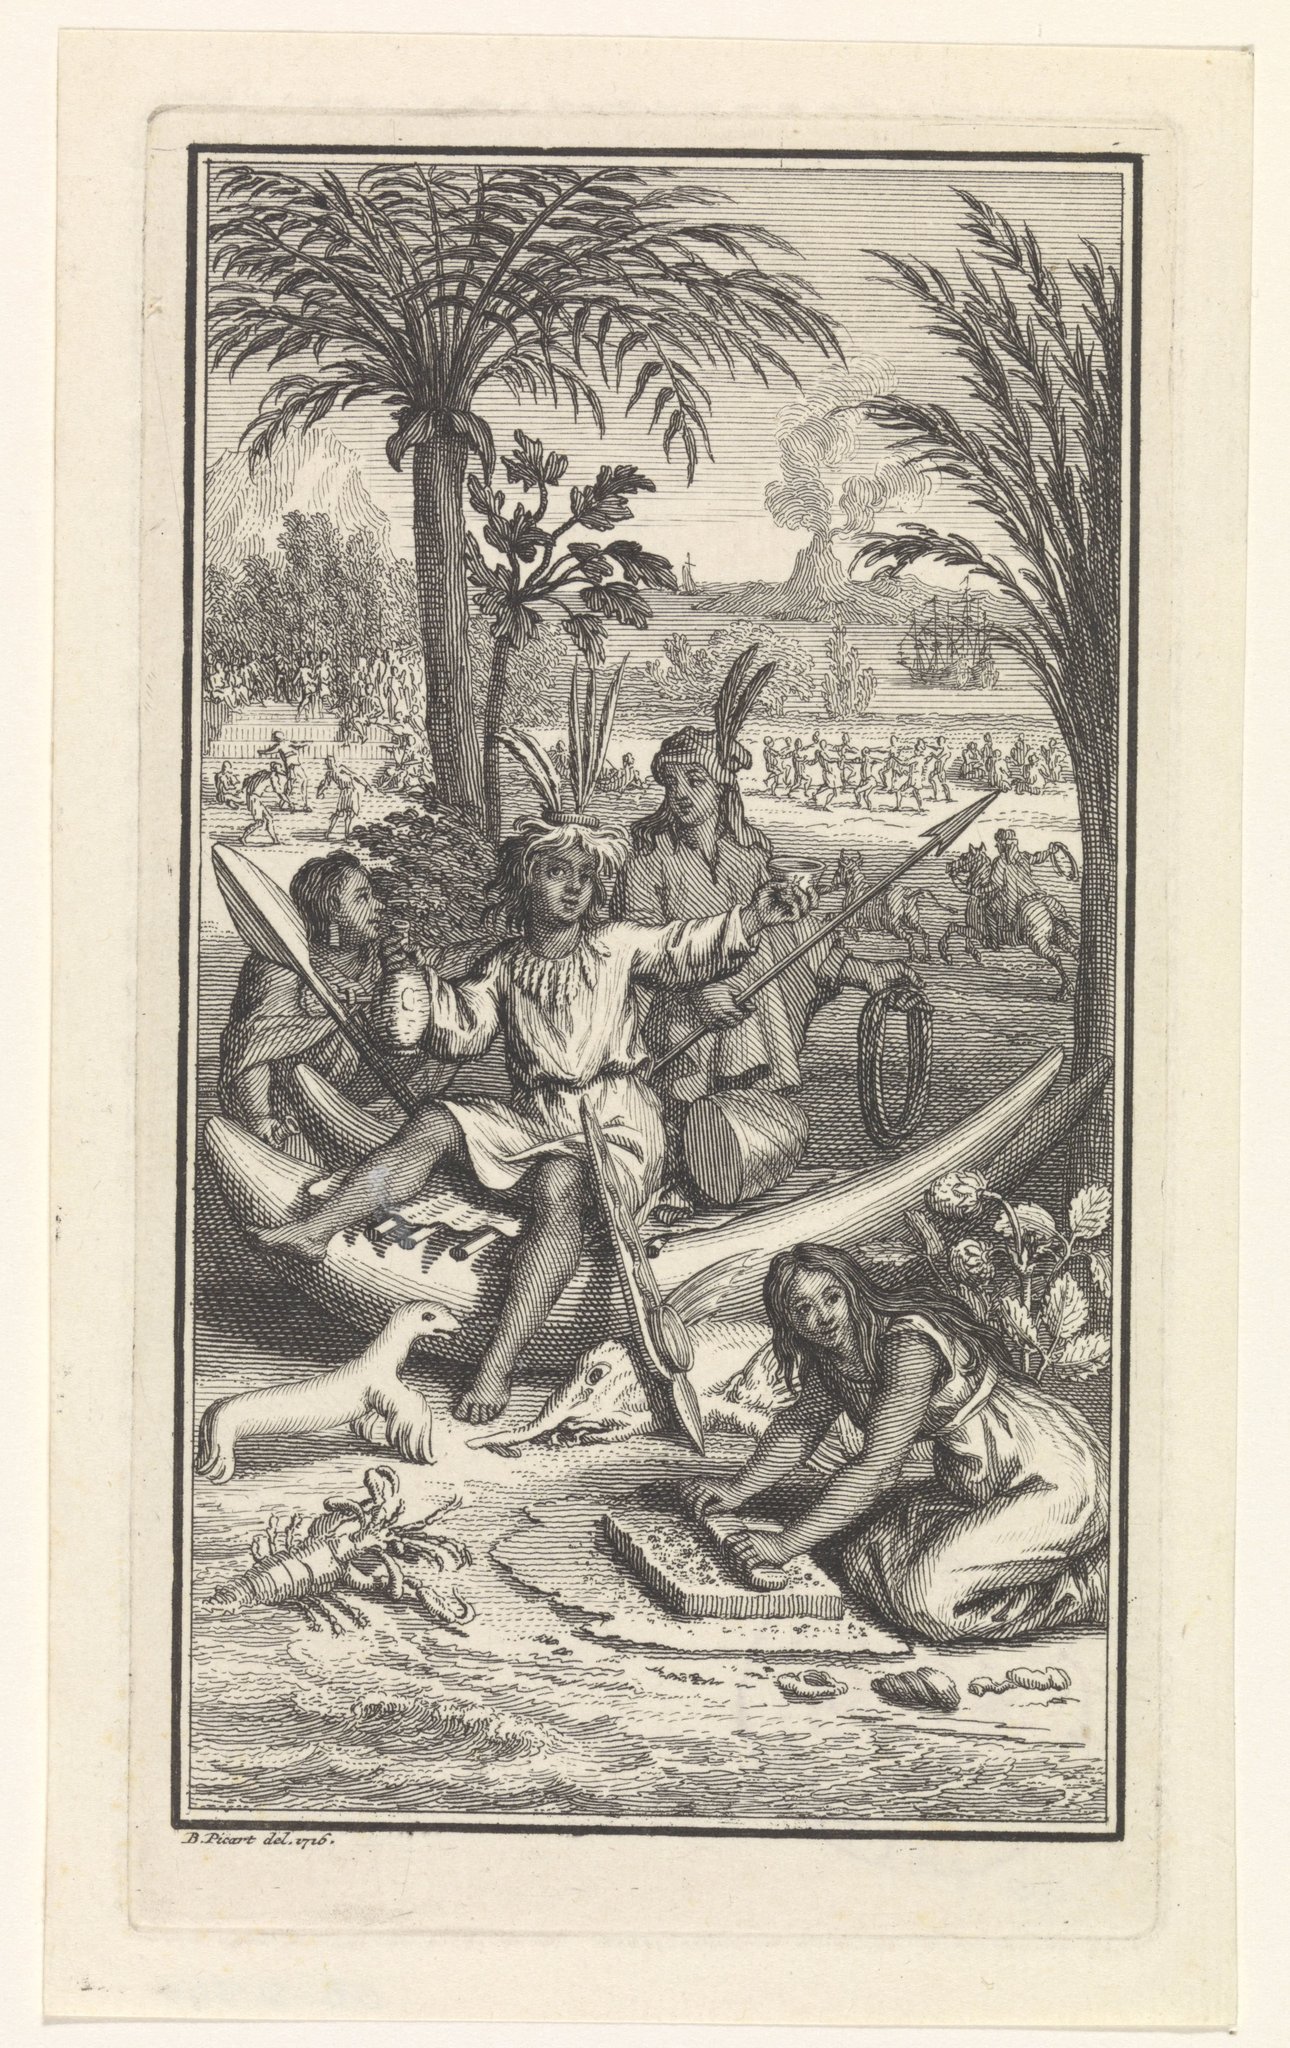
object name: book illustration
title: Dagelijkse bezigheden van Indianen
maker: bernard picart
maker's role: draughtsman, print maker, publisher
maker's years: 1673-1733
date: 1716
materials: paper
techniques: engraving, etching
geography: amsterdam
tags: ritual practices ~ american indian religions, cleaning of material, rowing-boat, canoe, etc., native peoples of the americas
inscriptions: collector's mark: Lugt 240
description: Landschap met op de voorgrond een vrouw die op het strand aan het werk is. Een met veren getooide man zit op een kano en houdt zijn beker omhoog. Op de achtergrond zijn enkele rituelen en ceremonies voorgesteld.